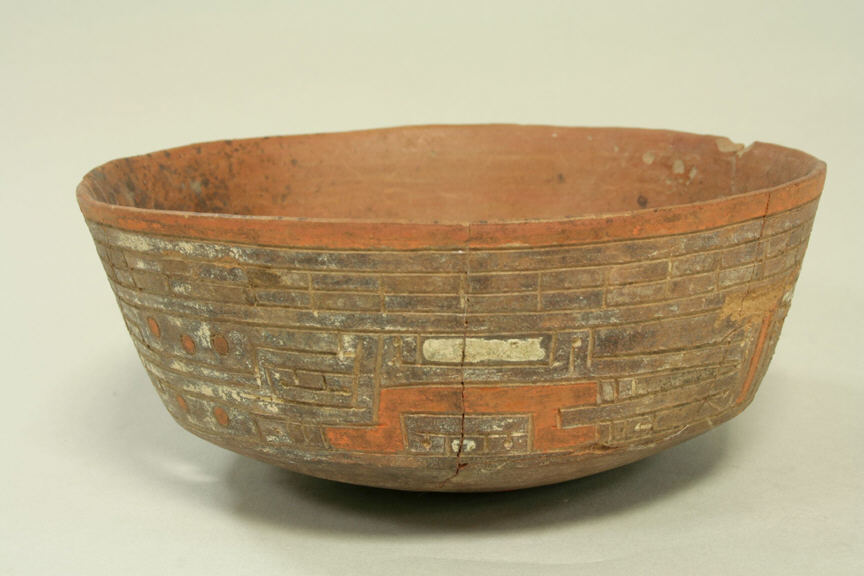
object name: bowl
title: Incised bowl with fox motif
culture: paracas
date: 500-201 BCE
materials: ceramic, pigment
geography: peru